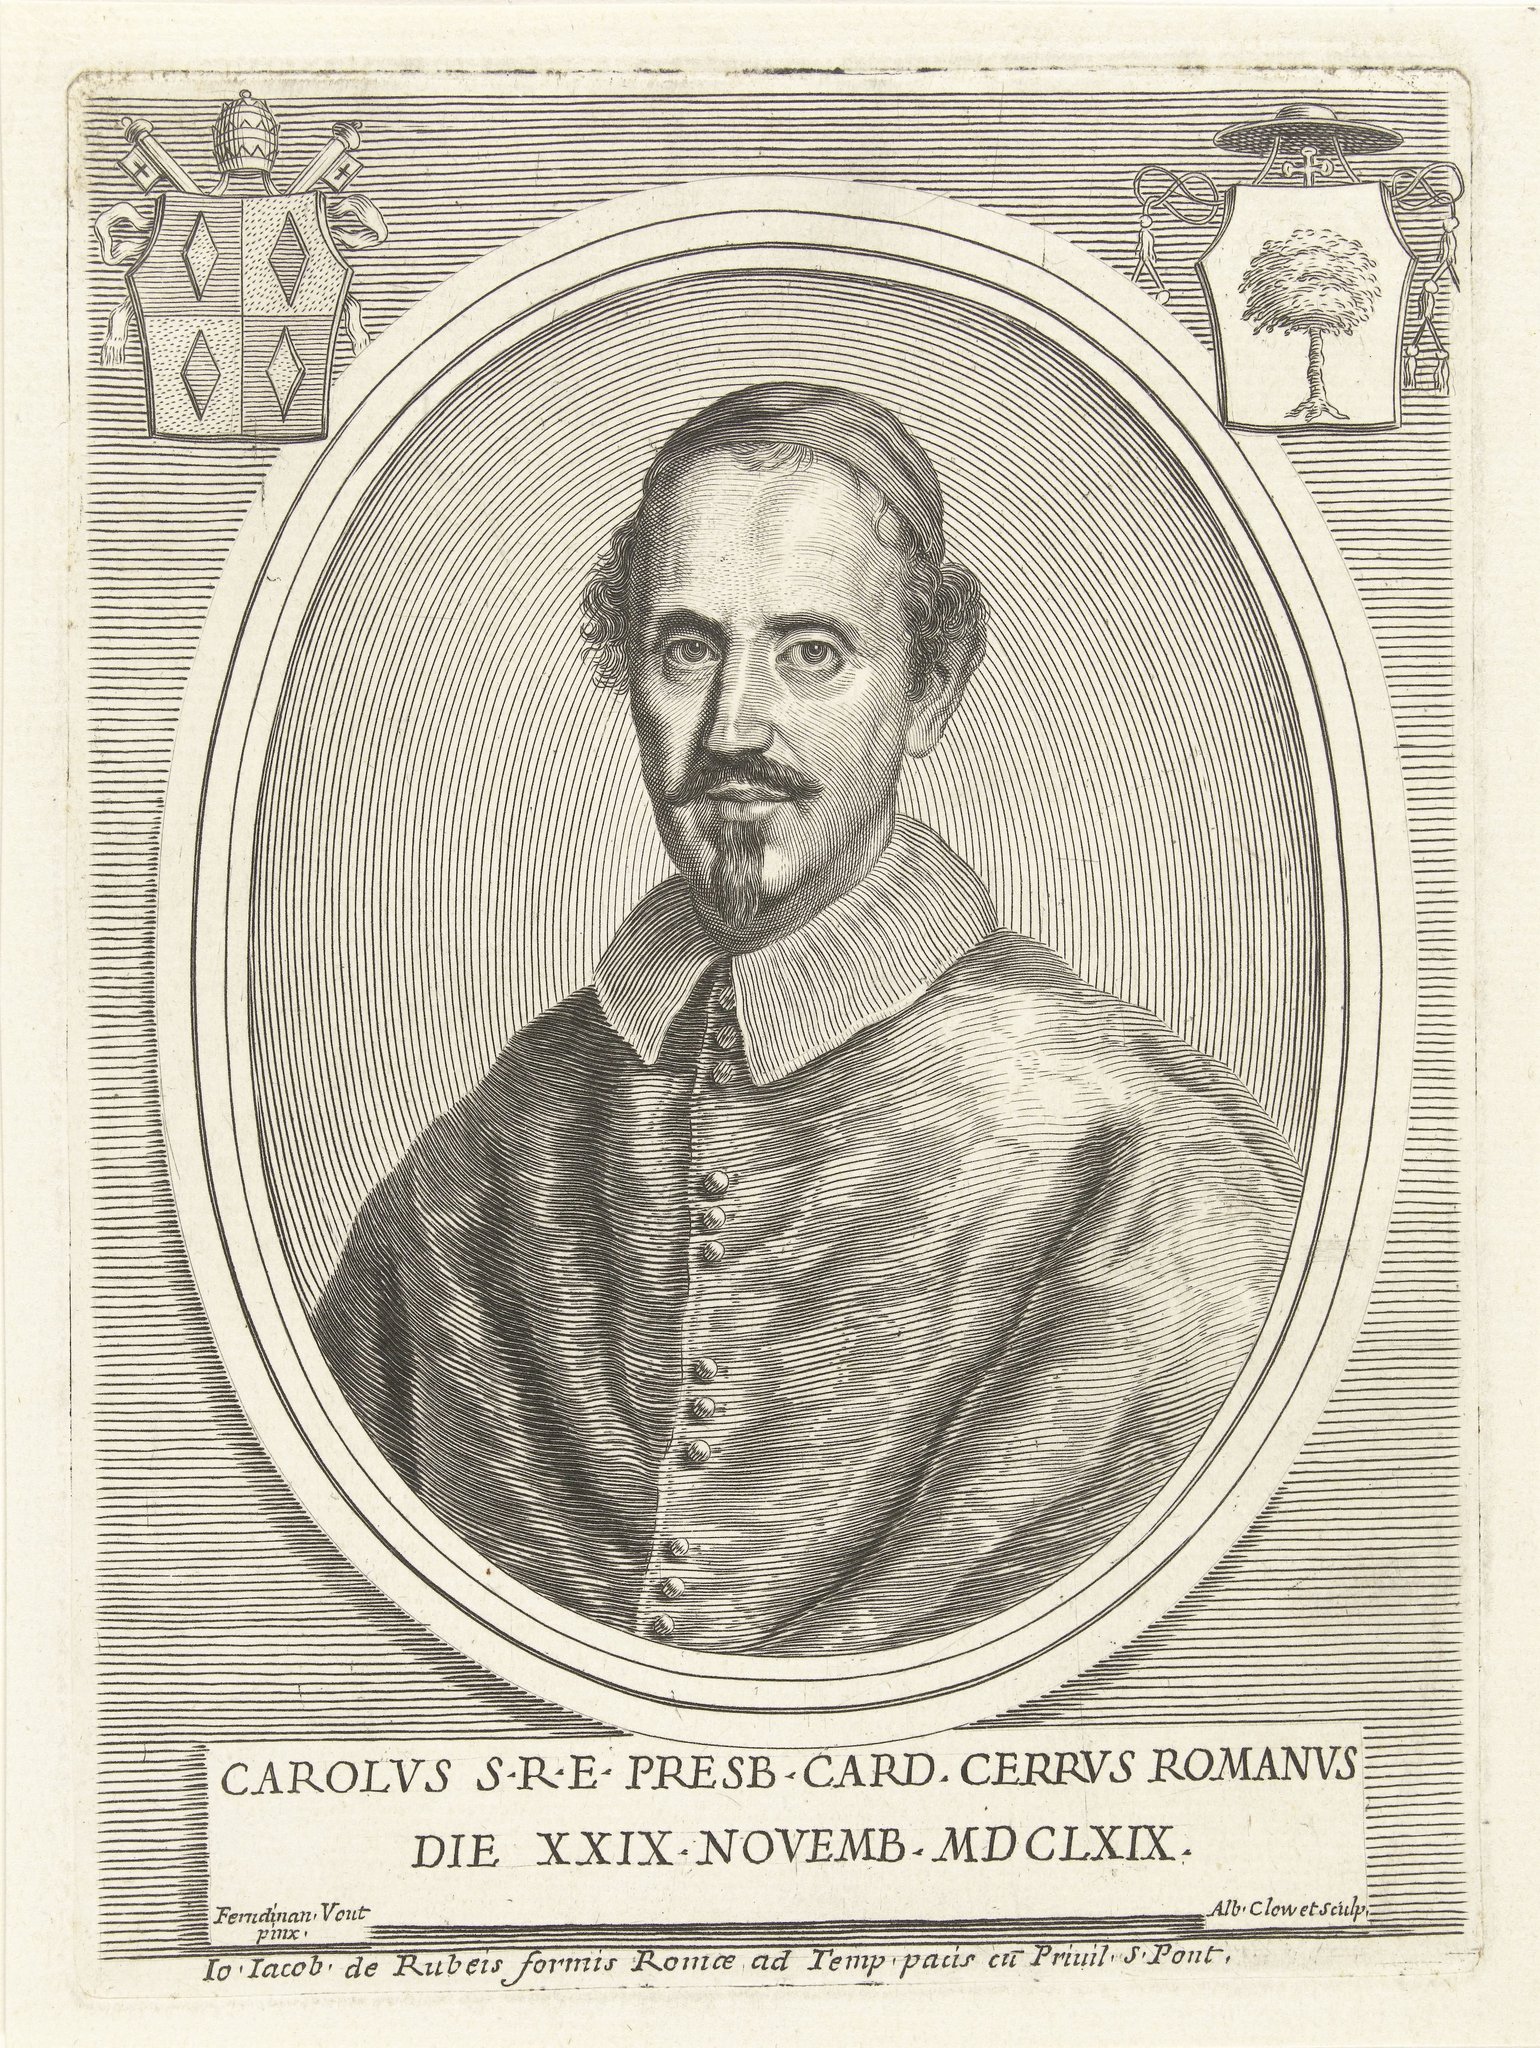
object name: print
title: Portret van kardinaal Carlo Cerri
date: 1669-1679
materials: paper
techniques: engraving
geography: rome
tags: rome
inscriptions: collector's mark: Lugt 2228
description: Portret in ovale lijst van kardinaal Carlo Cerri. Buste naar links. Bovenaan links het wapen van paus Clemens IX, bovenaan rechts het wapen van kardinaal Carlo Cerri. De prent heeft een Latijns onderschrift met gegevens over de geportretteerde.